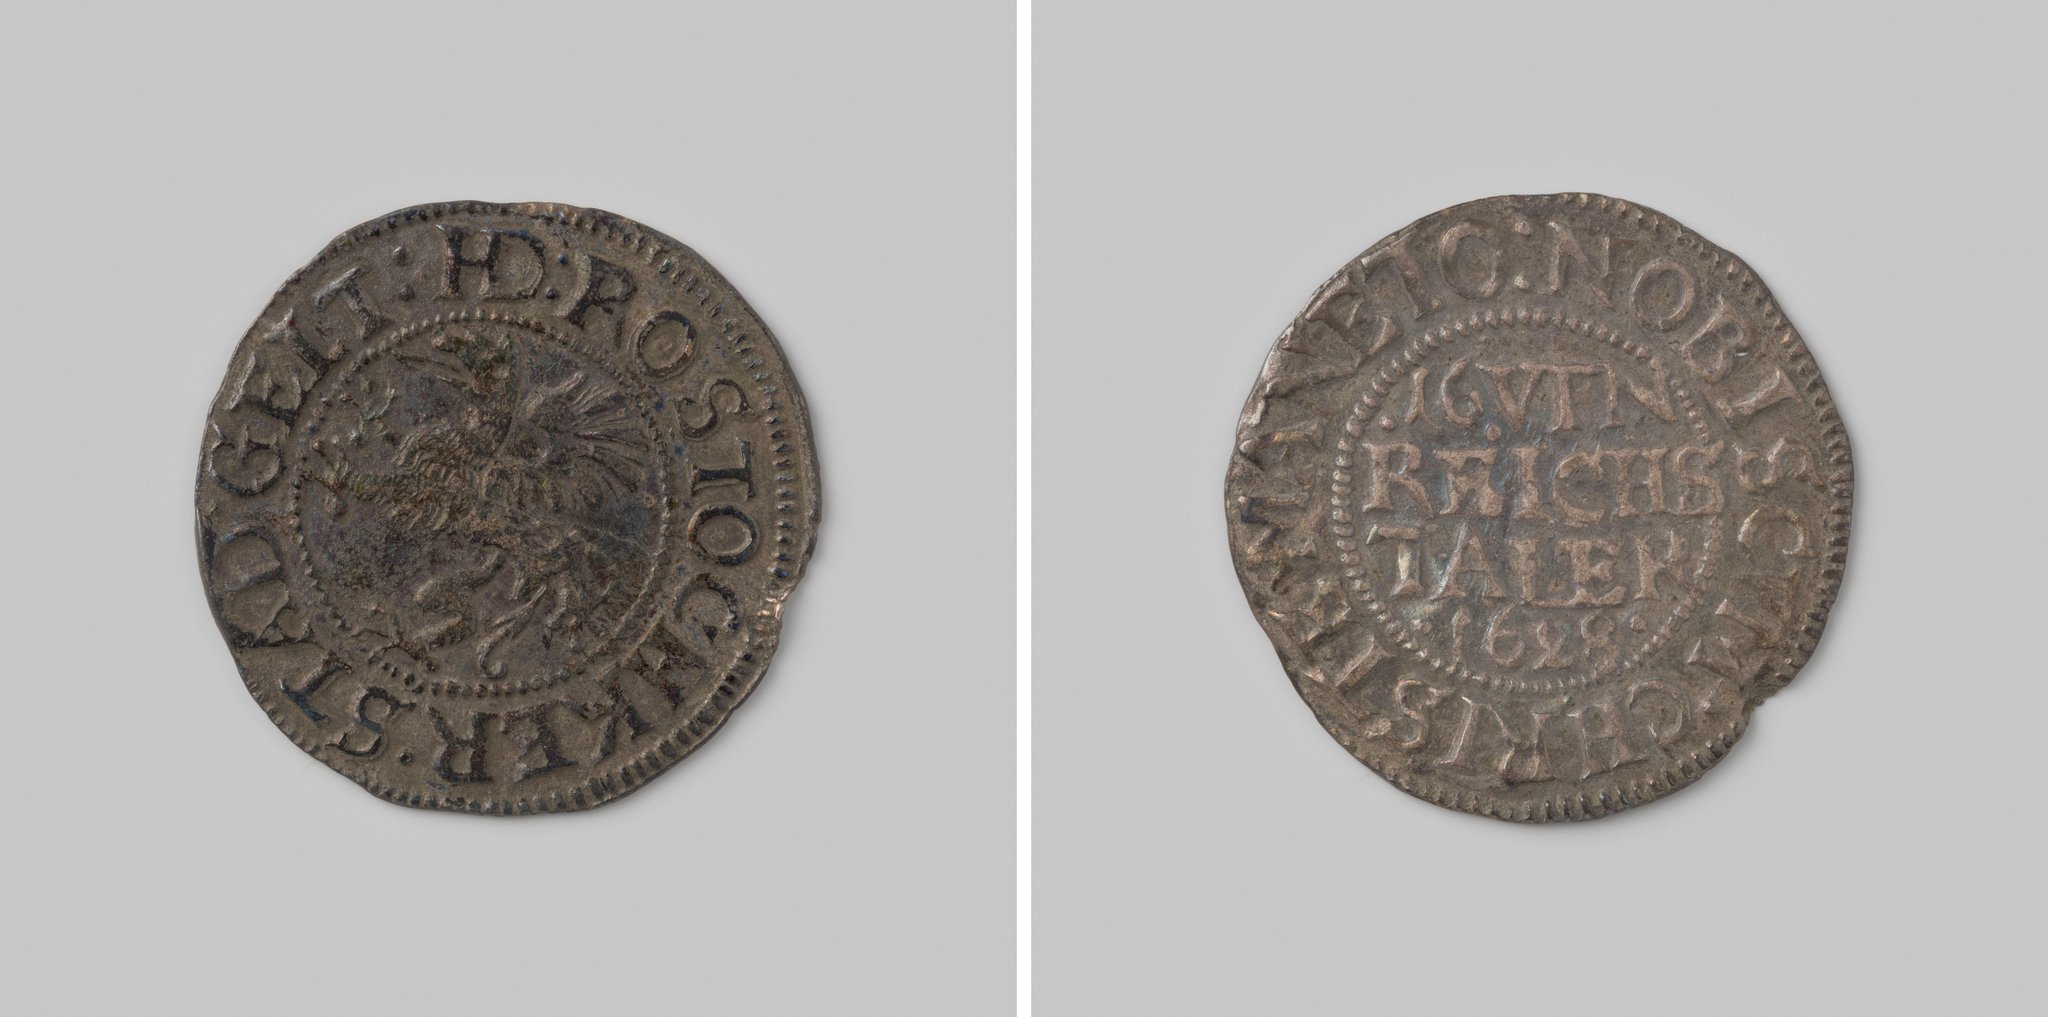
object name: zestiende rijkstaler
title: Stad Rostock, 1/16 Reichsthaler, 1628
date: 1628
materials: silver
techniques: striking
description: Zilveren munt. Voorzijde: griffioen naar links. Keerzijde: waarde-aanduiding in drie regels, waaronder jaartal.